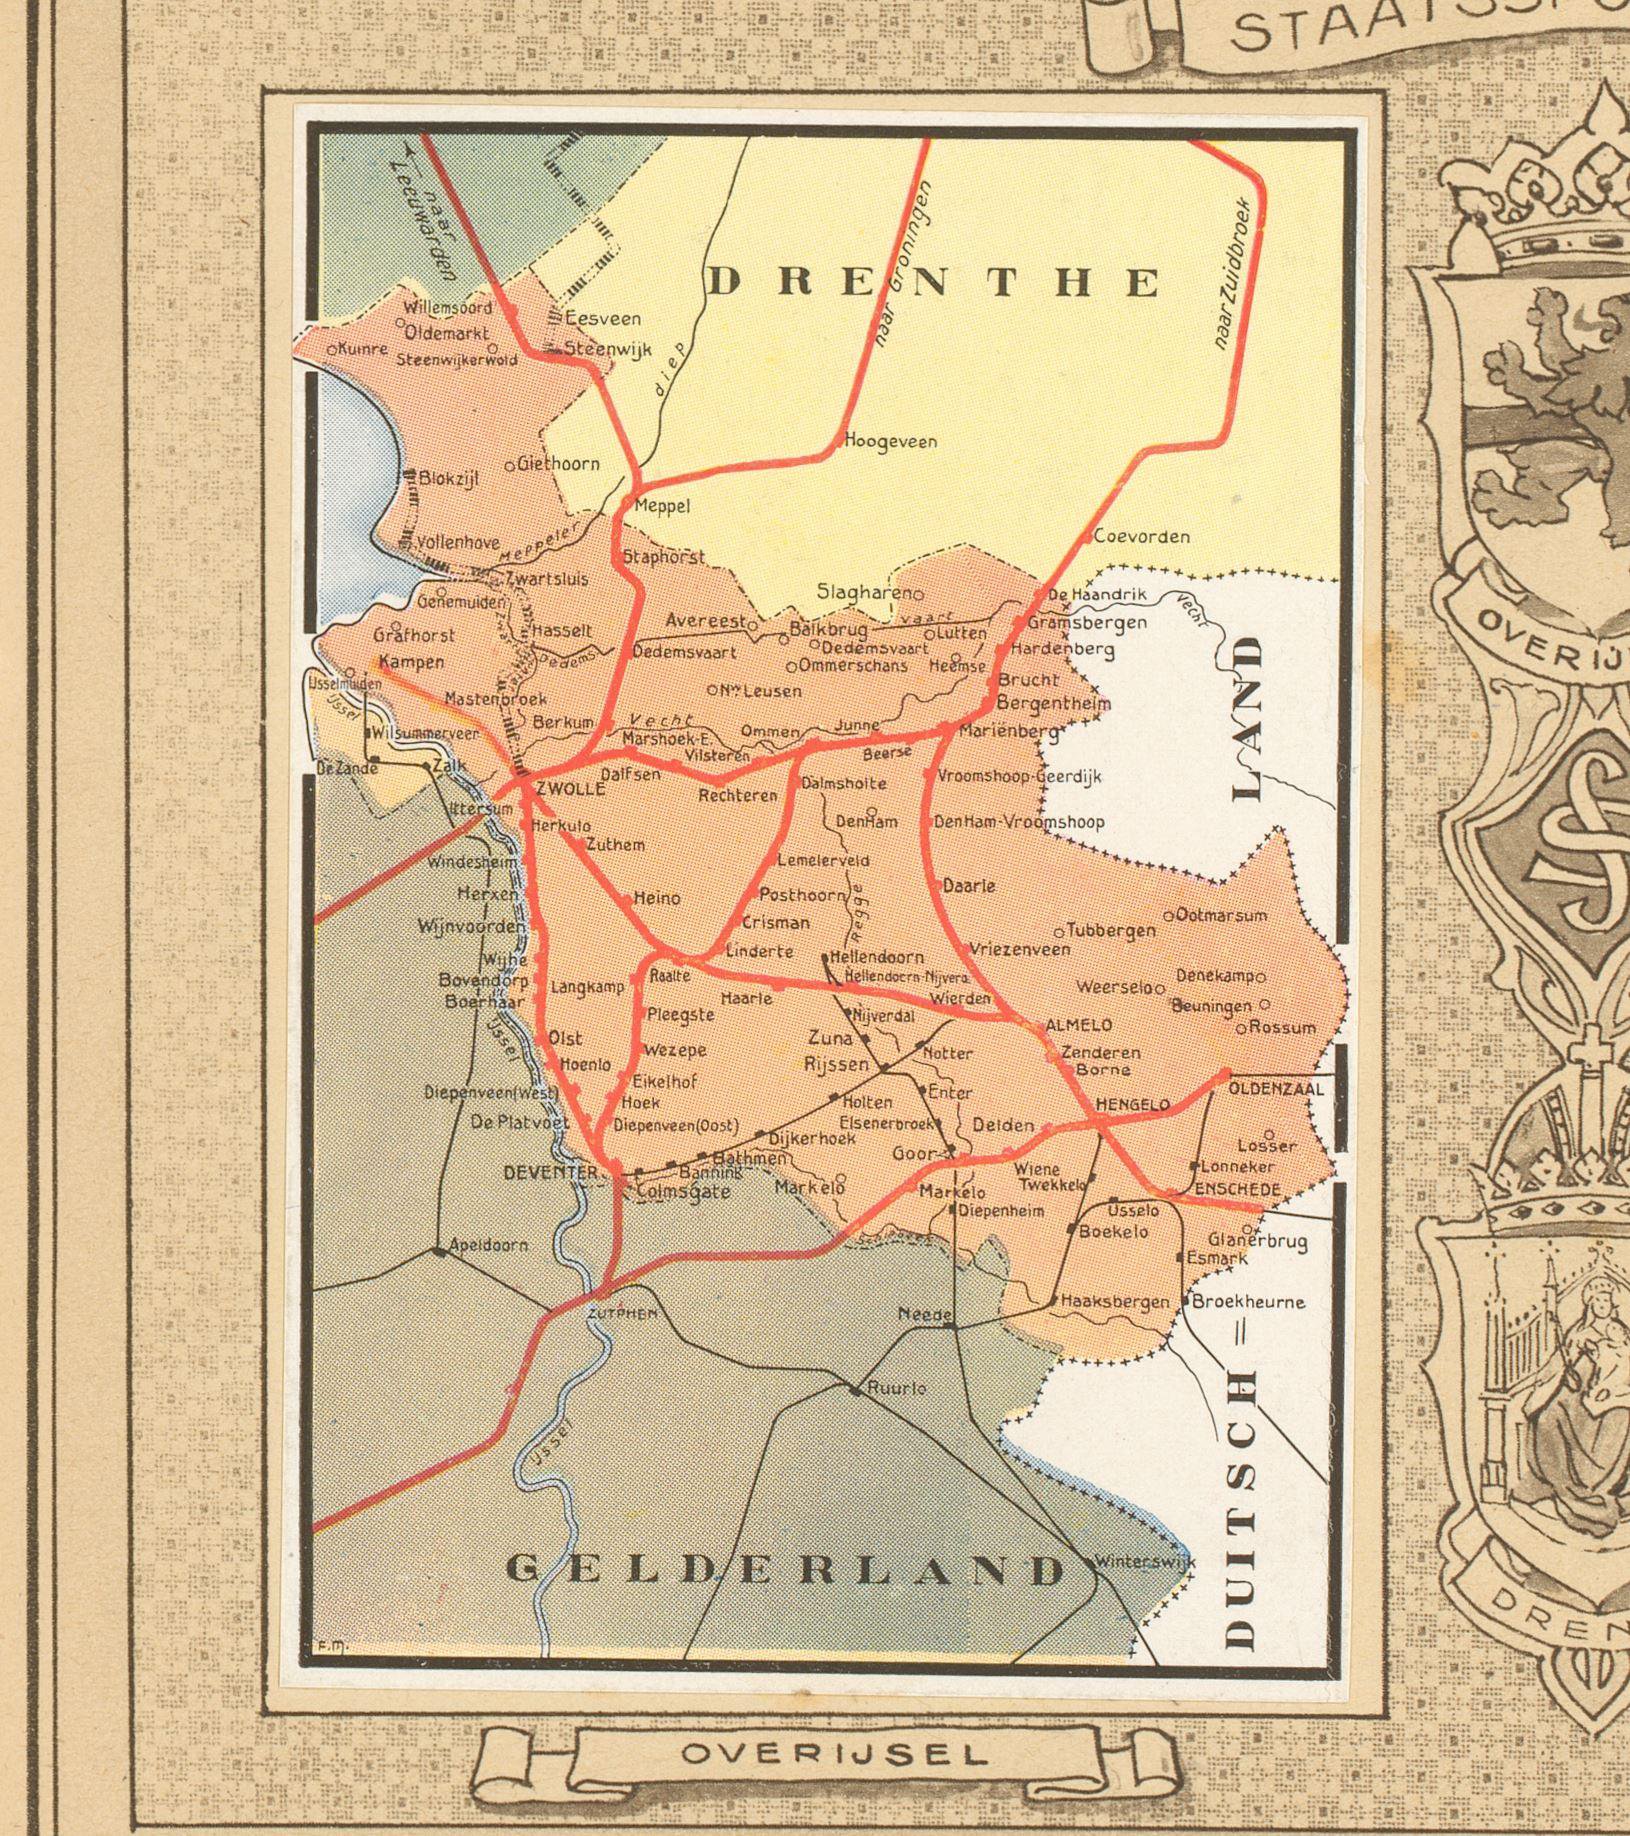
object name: photomechanical print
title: Spoorwegenkaart van Gelderland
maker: Anonymous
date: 1915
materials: paper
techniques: printing block, rotogravure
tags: maps of separate countries or regions, railway, tramway; rack railway, gelderland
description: Deze prent maakt deel uit van een album.